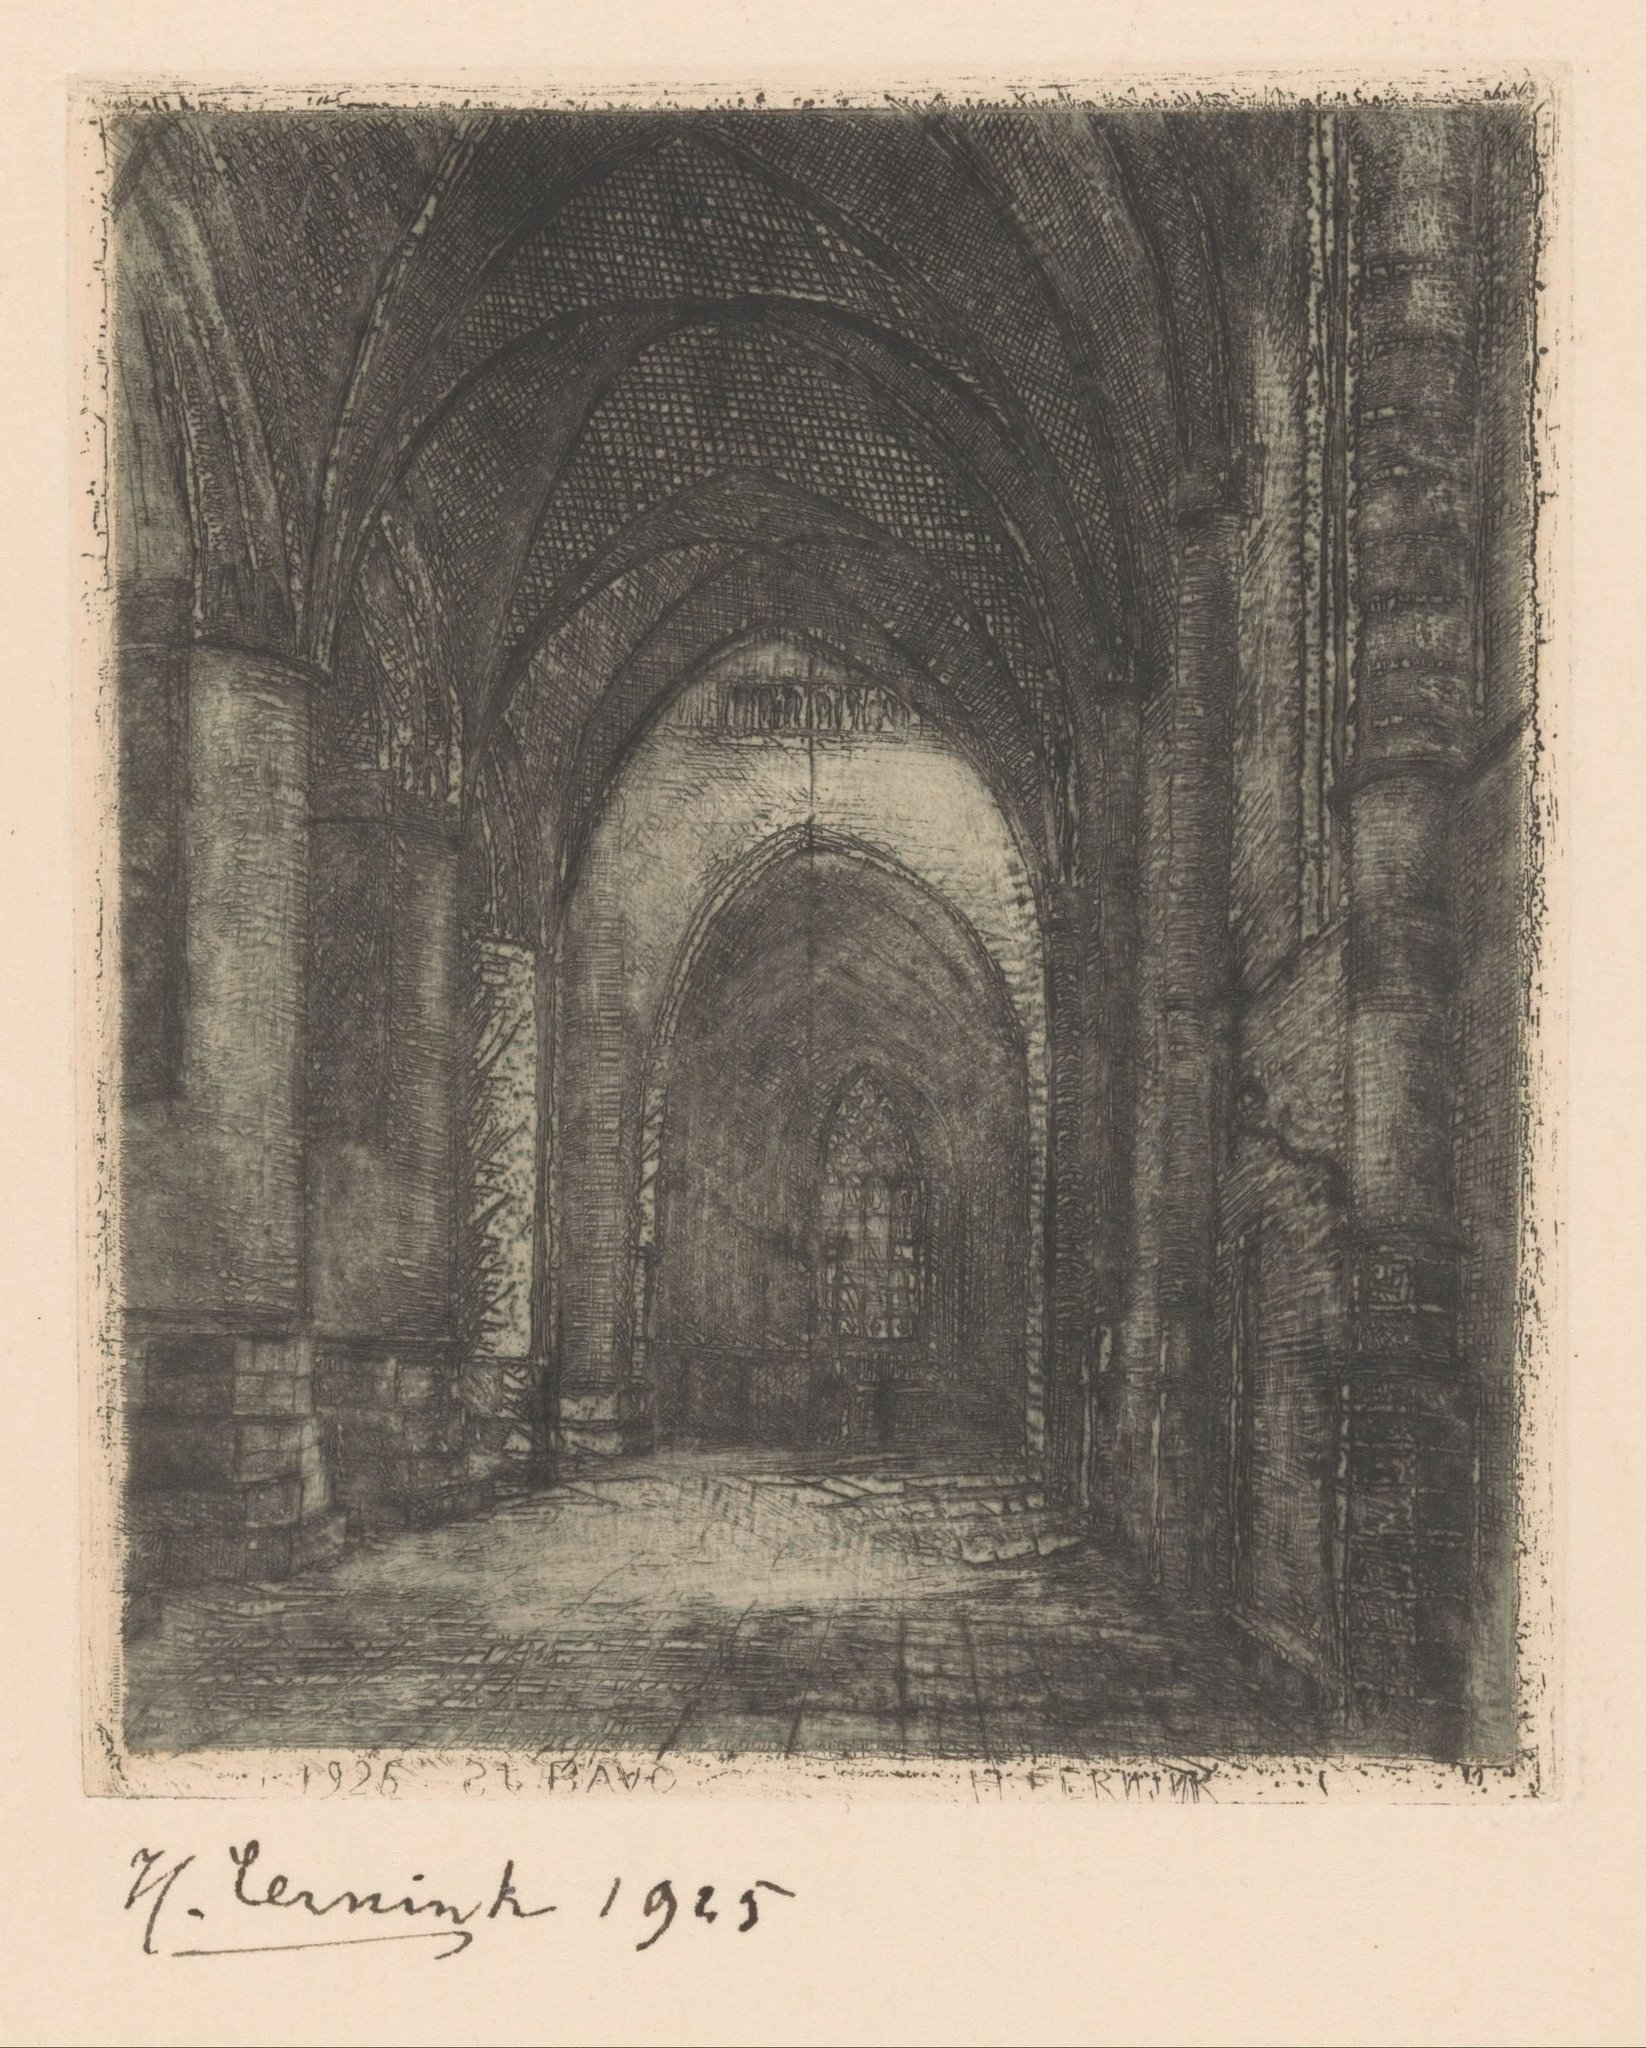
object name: print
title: Zijbeuk van de Grote of Sint-Bavokerk in Haarlem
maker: hendricus nicolaas johannes eernink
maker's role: print maker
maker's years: 1874-1945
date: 1925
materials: paper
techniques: etching, intaglio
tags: parts of church interior: aisle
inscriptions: collector's mark: Lugt 2228, collector's mark: Lugt 2760